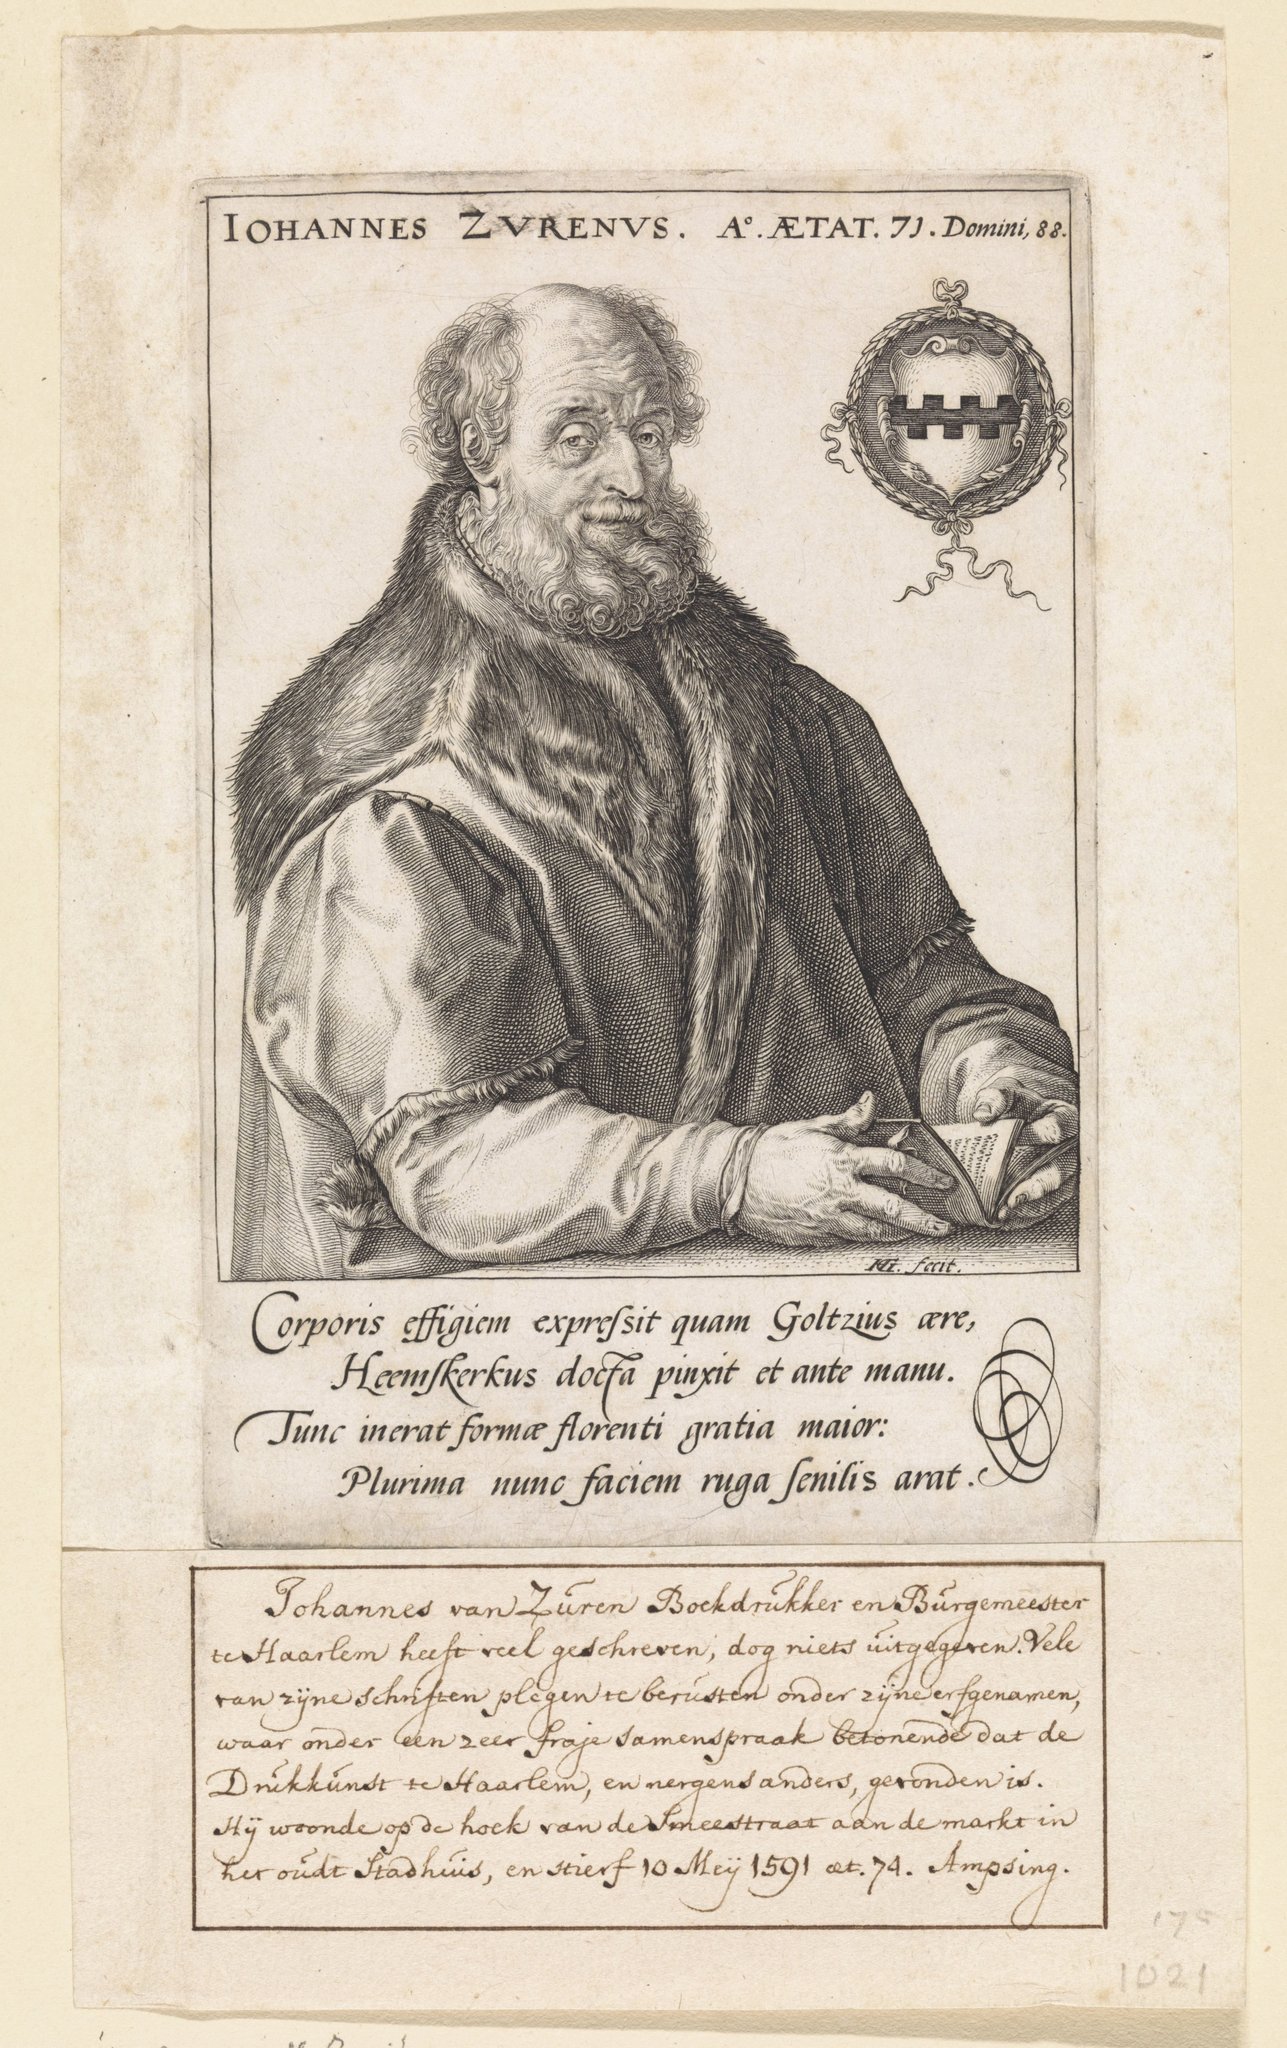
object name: print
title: Portret Johan van Suren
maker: hendrick goltzius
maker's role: draughtsman, painter, print maker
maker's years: 1558-1617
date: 1588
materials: paper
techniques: engraving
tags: boekdrukker, johan van zuren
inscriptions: inscription: ‘Corporis effigiem expressit quam Goltzius aere...senilis arat.’, monogram: ‘HG fecit’, annotation: ‘Johannes van Zuren, boekdrukker en burgemeester van Haarlem heeft veel geschreven, dog niets uitgegeven.., en stierf 10 Mei 1591 aet. 74. Ampsing.’, inscription: ‘IOHANNES ZURENUS . Ao AETAT. 71. Domini 88’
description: Portret van de drukker/uitgever en burgemeester van Haarlem Jan van Suren (1517-1591). Van Suren is hier 71 jaar oud. Ten halven lijve afgebeeld achter een tafel, min of meer op de rechterzijde gezien, de blik naar de beschouwer. In zijn handen een boekje. Hij is gekleed in een mantel afgezet met bont. Rechtsboven zijn wapen. Vier regels onderschrift in Latijn.